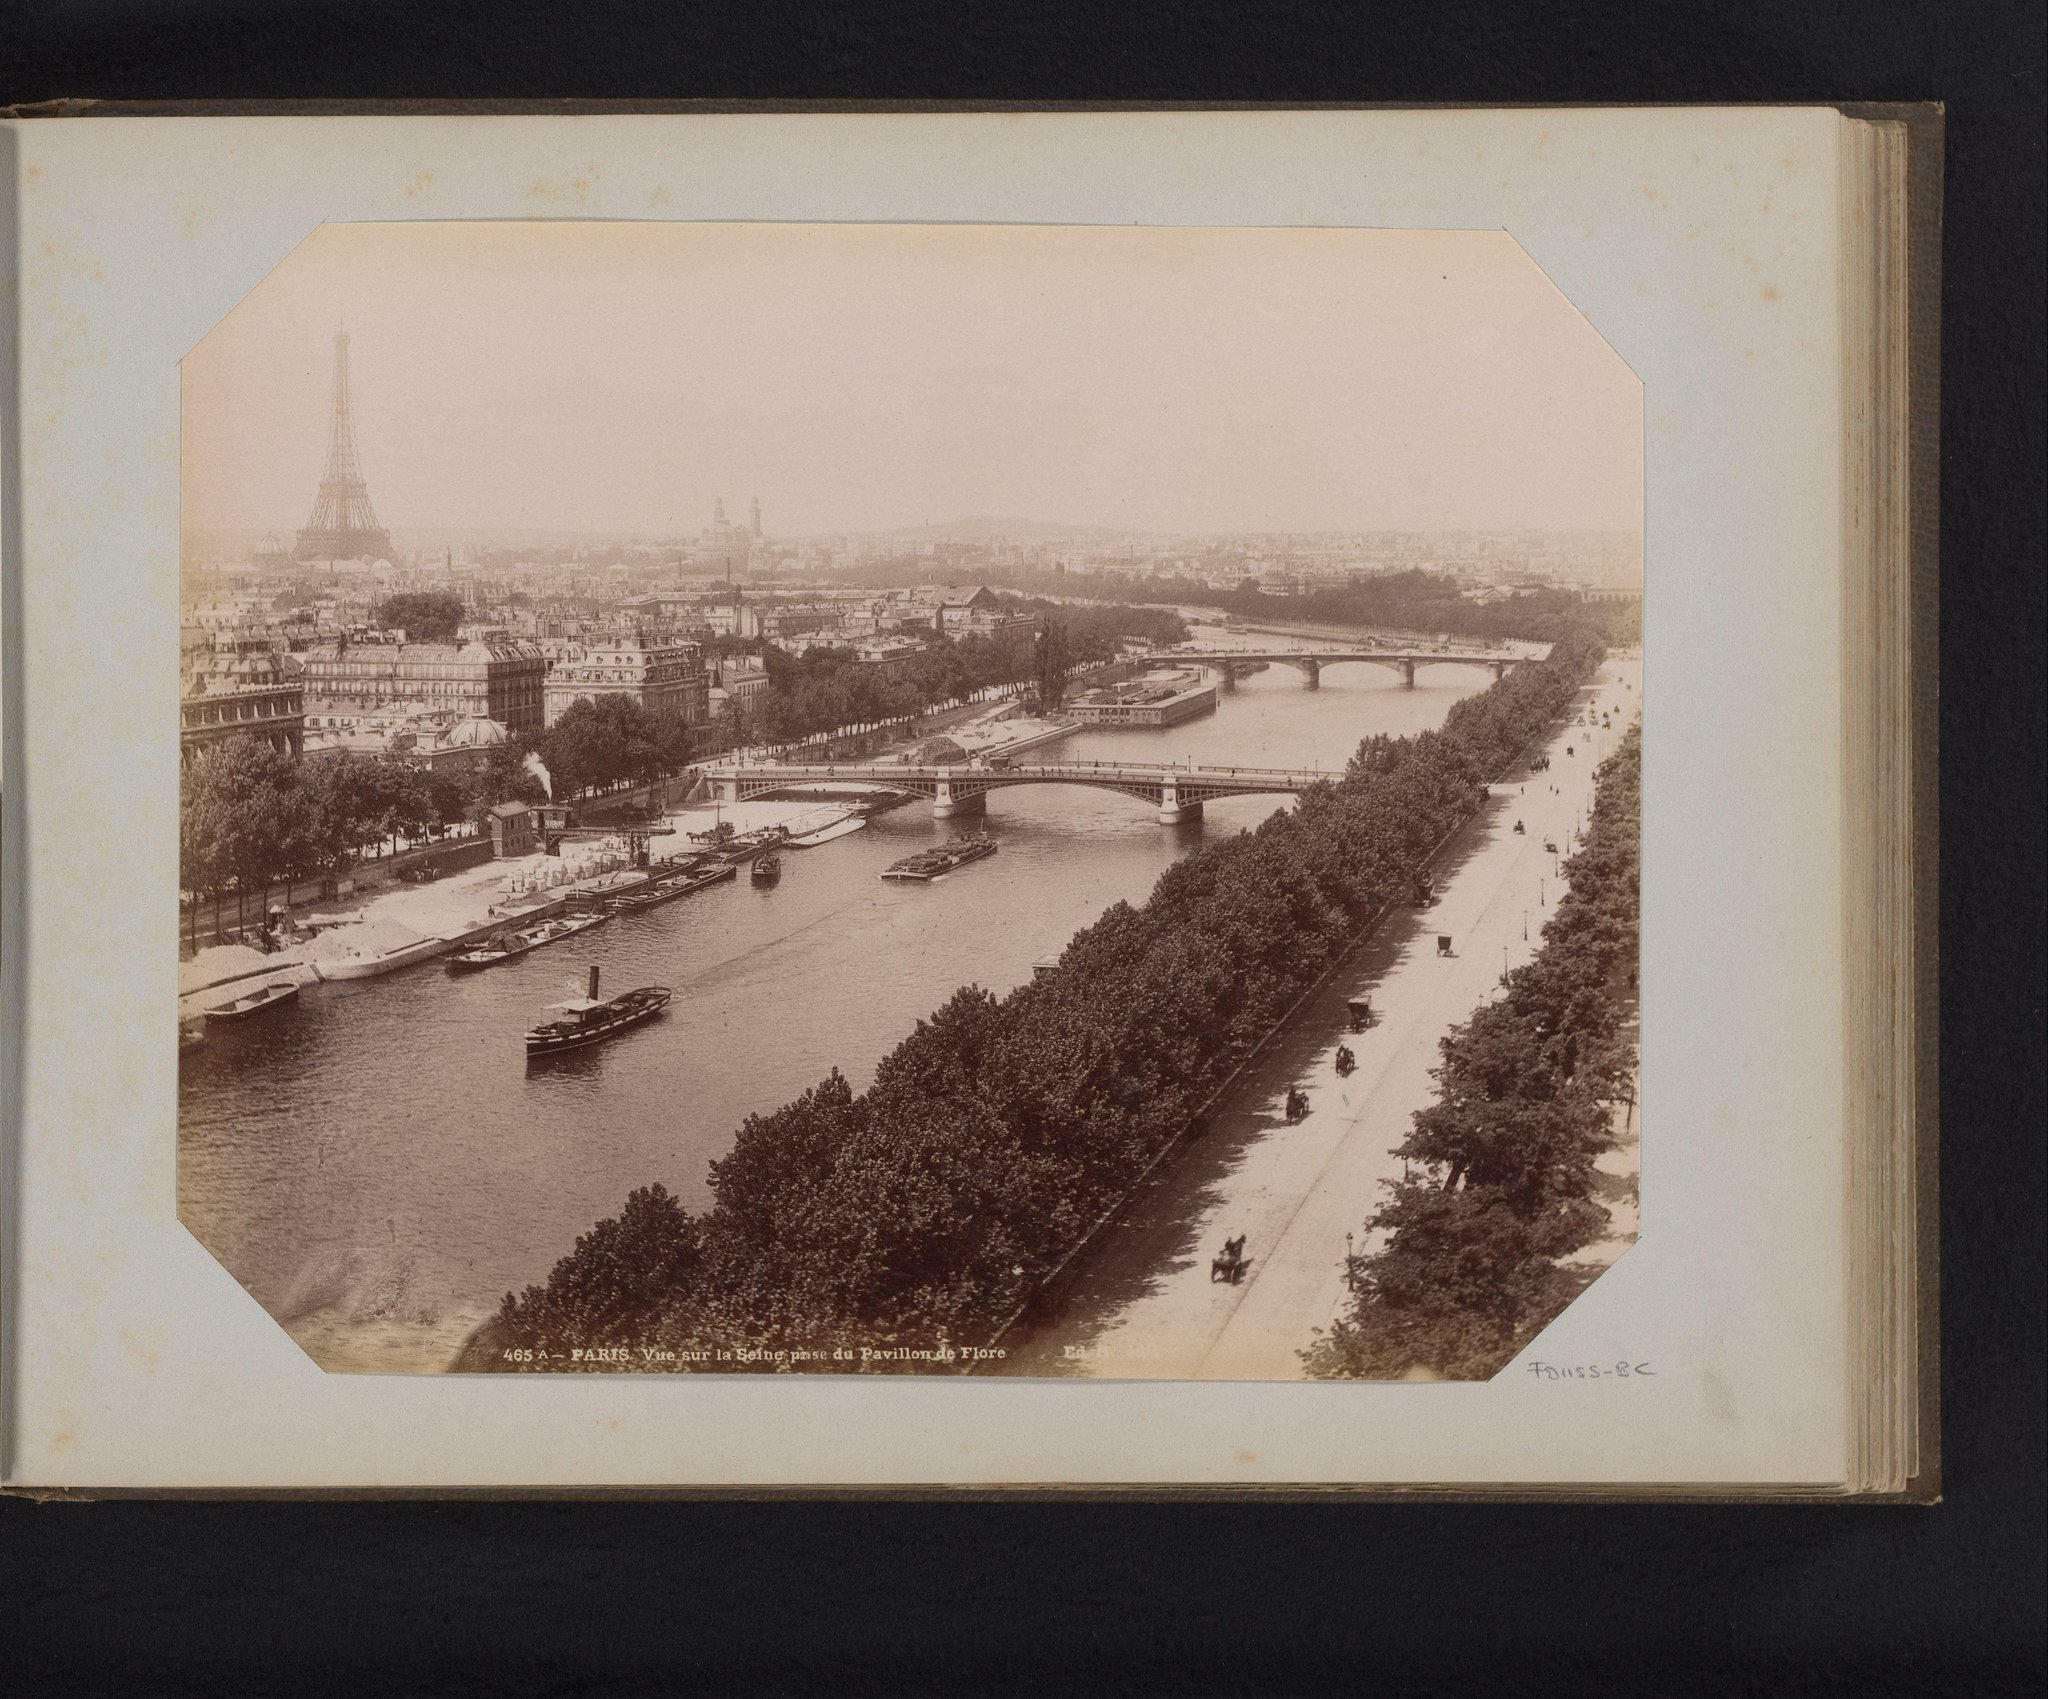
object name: album leaf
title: Gezicht op Parijs met de Eiffeltoren en de Seine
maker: edouard hautecoer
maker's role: publisher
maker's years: 1847-1904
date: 1890-1898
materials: photographic support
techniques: albumen print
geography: paris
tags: city-view in general; 'veduta' (+ city(-scape) with figures, staffage), paris, eiffel tower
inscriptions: inscription: ‘465A - Paris. Vue sur la Seine prise du Pavillon de Flore. Ed. H. édit’, retailer's mark: ‘E. Hautecoeur/ Estampes Photographies/ 35 Avenue de l'Opéra, 35/ Paris’